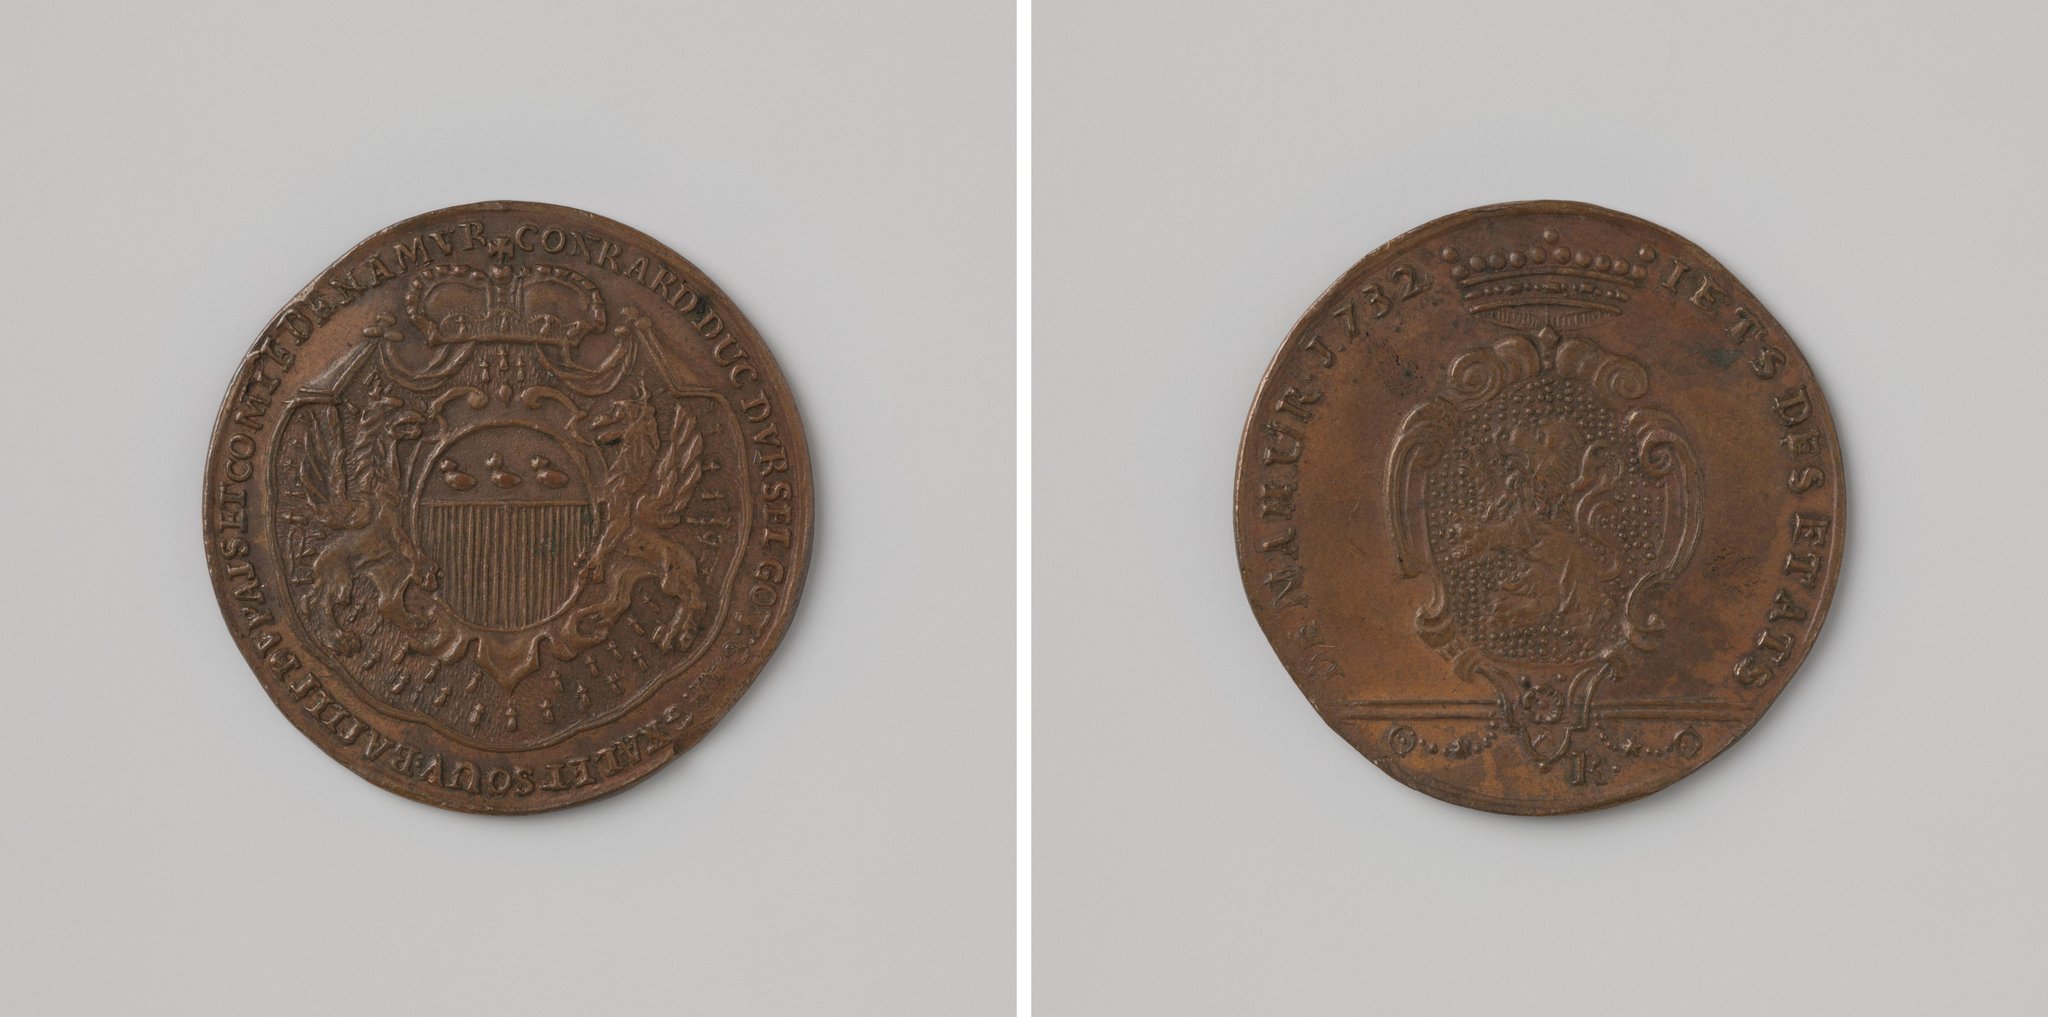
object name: jeton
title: Konrad, hertog van Ursel aangesteld als gouverneur van Namen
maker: philippe roëttiers (iii)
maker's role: medailleur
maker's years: 1686-1873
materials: copper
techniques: striking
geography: antwerp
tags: raad van namen, koenraad (hertog van ursel), namen (stad)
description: Koperen penning. Voorzijde: gekroond wapenschild geflankeerd door twee griffioenen binnen omschrift. Keerzijde: gekroond wapenschild binnen omschrift; afsnede: monogram